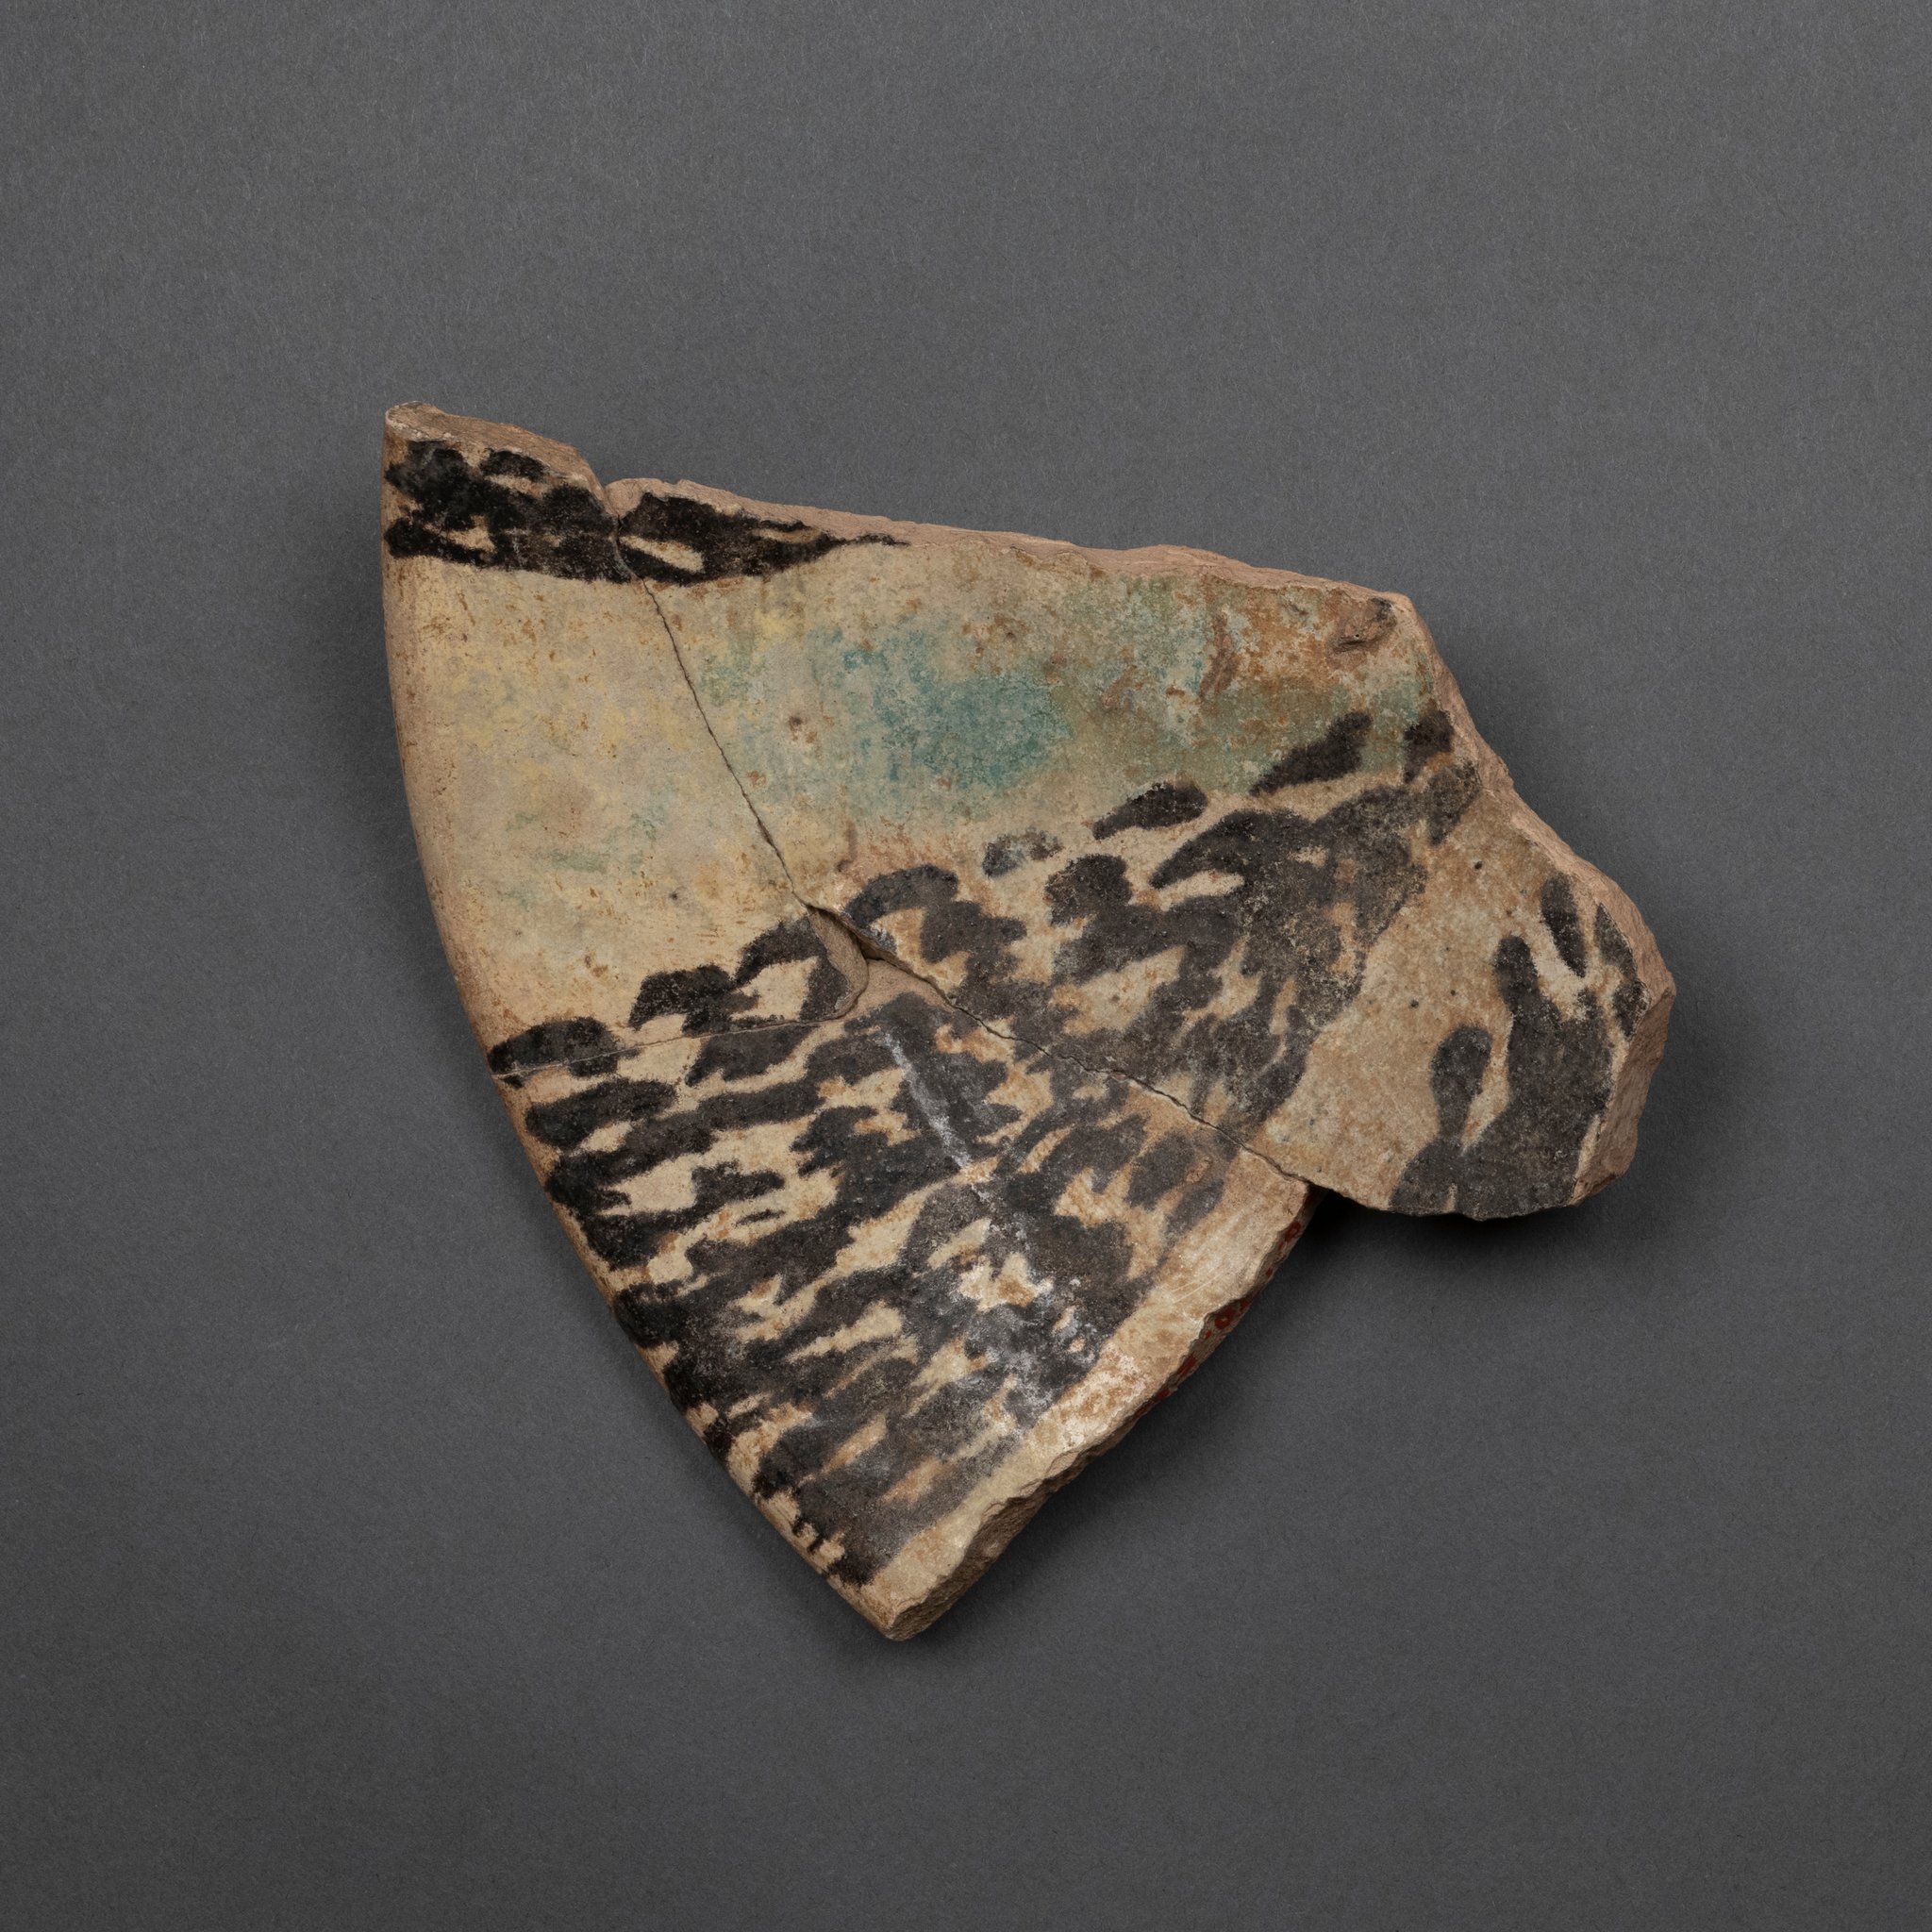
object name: plate fragment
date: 801-1000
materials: earthenware, glaze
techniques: polychrome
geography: iran